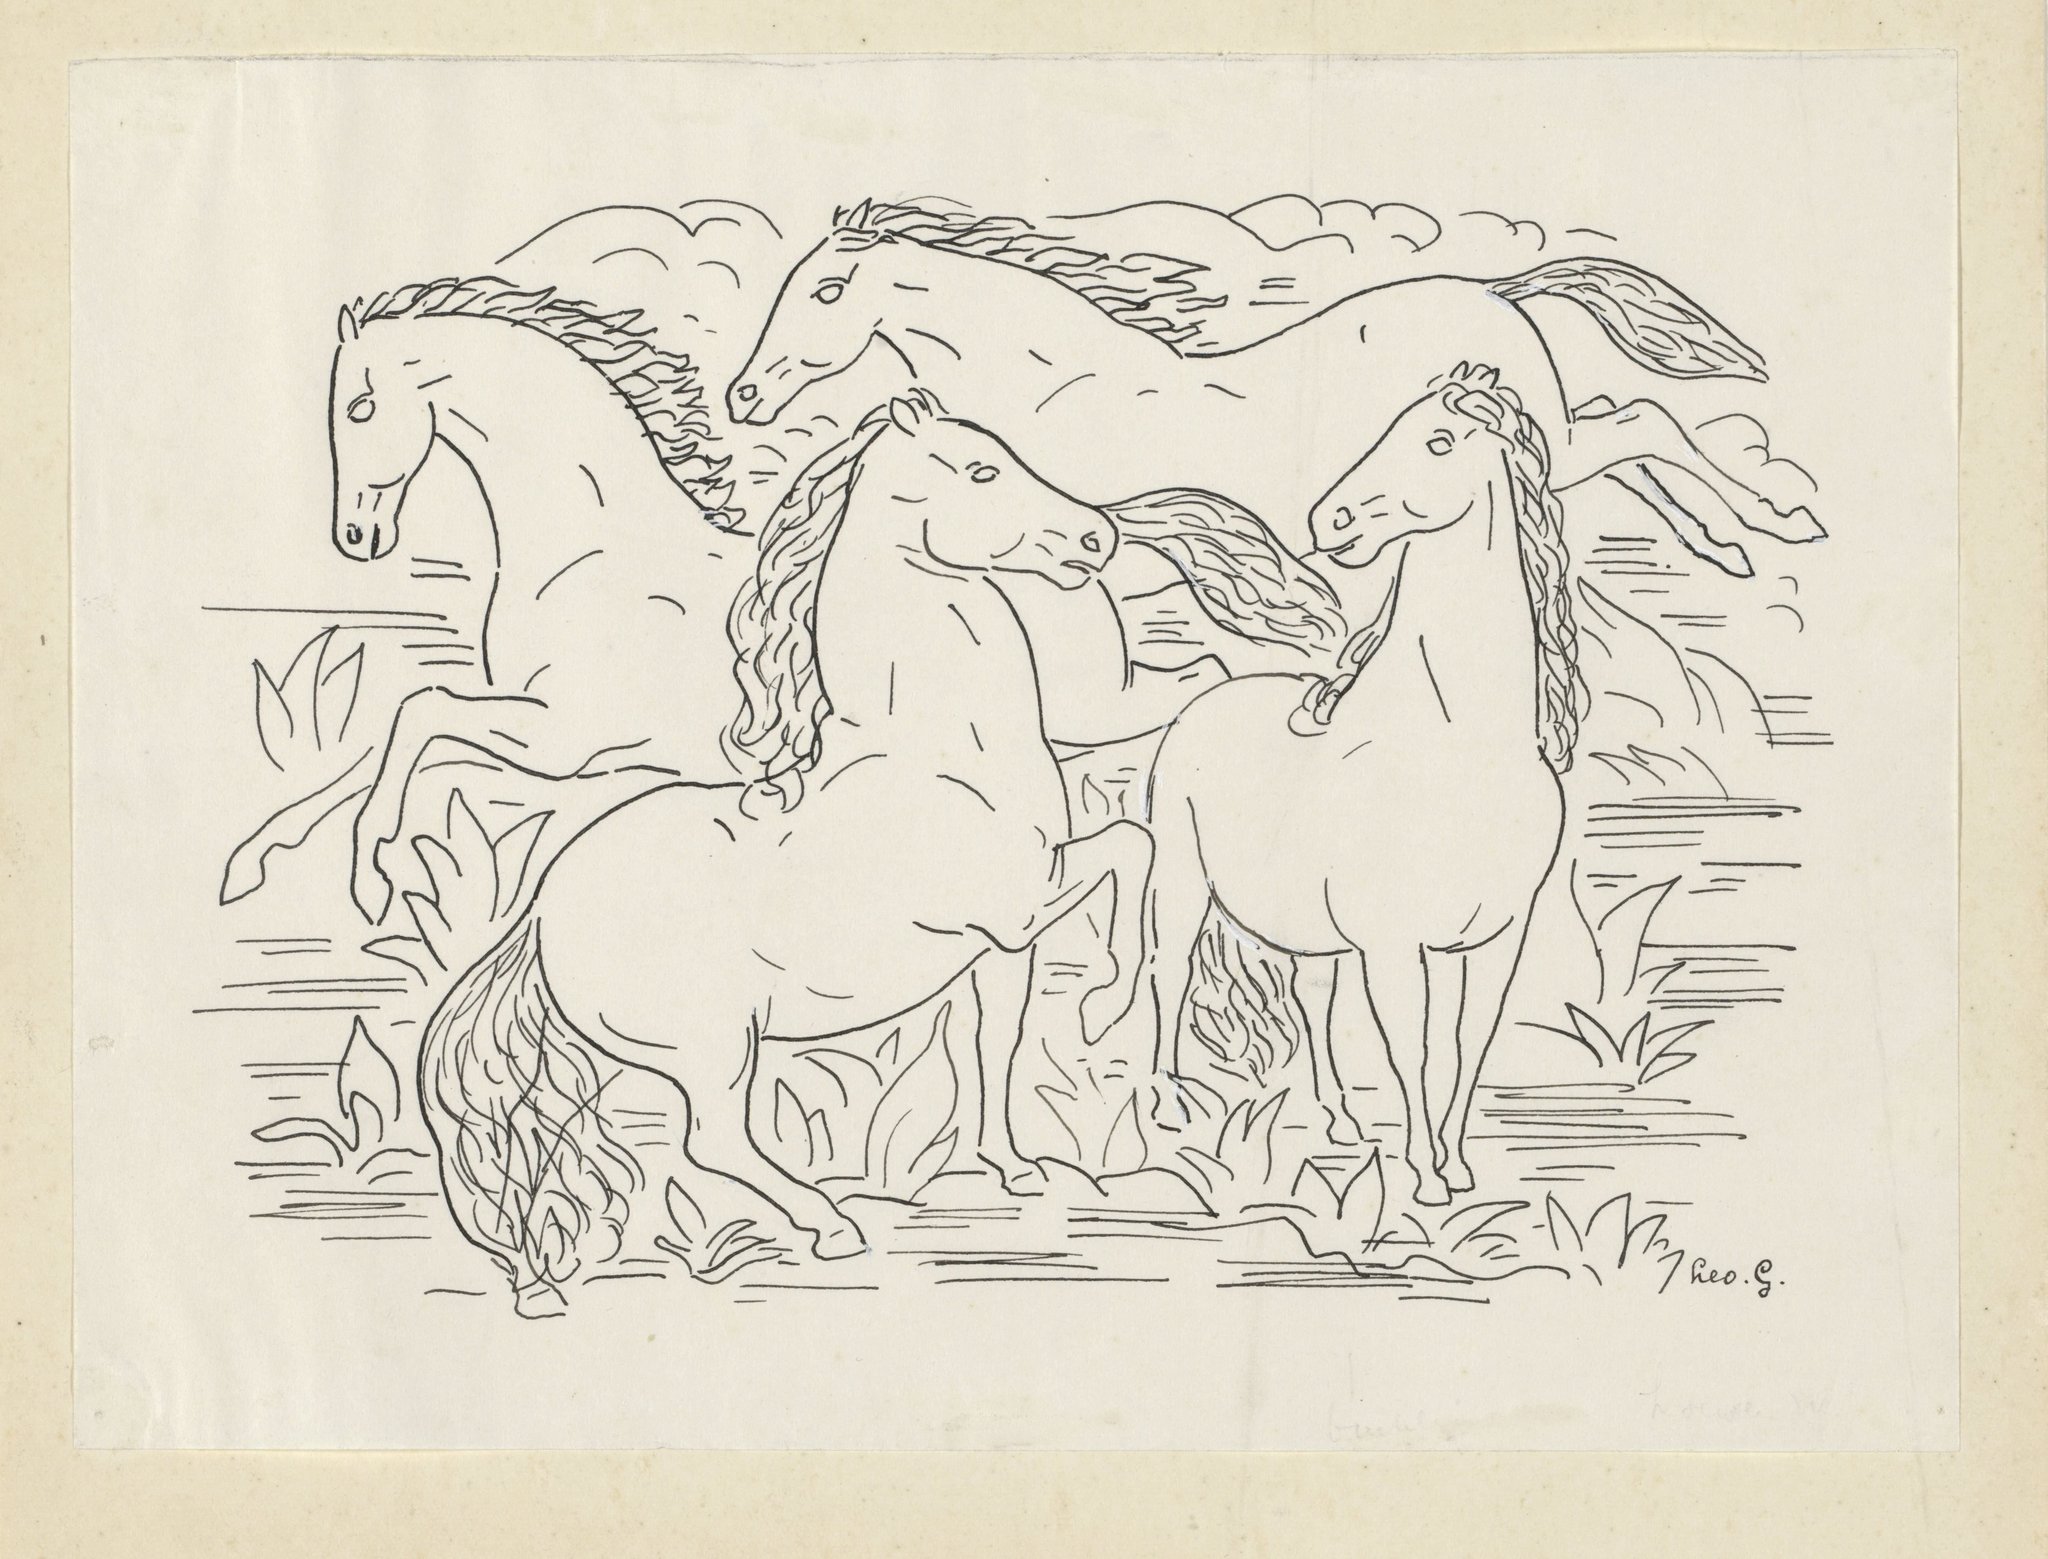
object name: drawing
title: Vier paarden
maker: leo gestel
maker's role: draughtsman, print maker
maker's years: 1881-1941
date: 1924-1941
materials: paint, ink, paper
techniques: pen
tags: horse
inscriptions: collector's mark: Lugt 2228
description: Mogelijk een ontwerp voor een vignet voor het Maandblad voor Beeldende Kunsten, uitgegeven vanaf 1924.